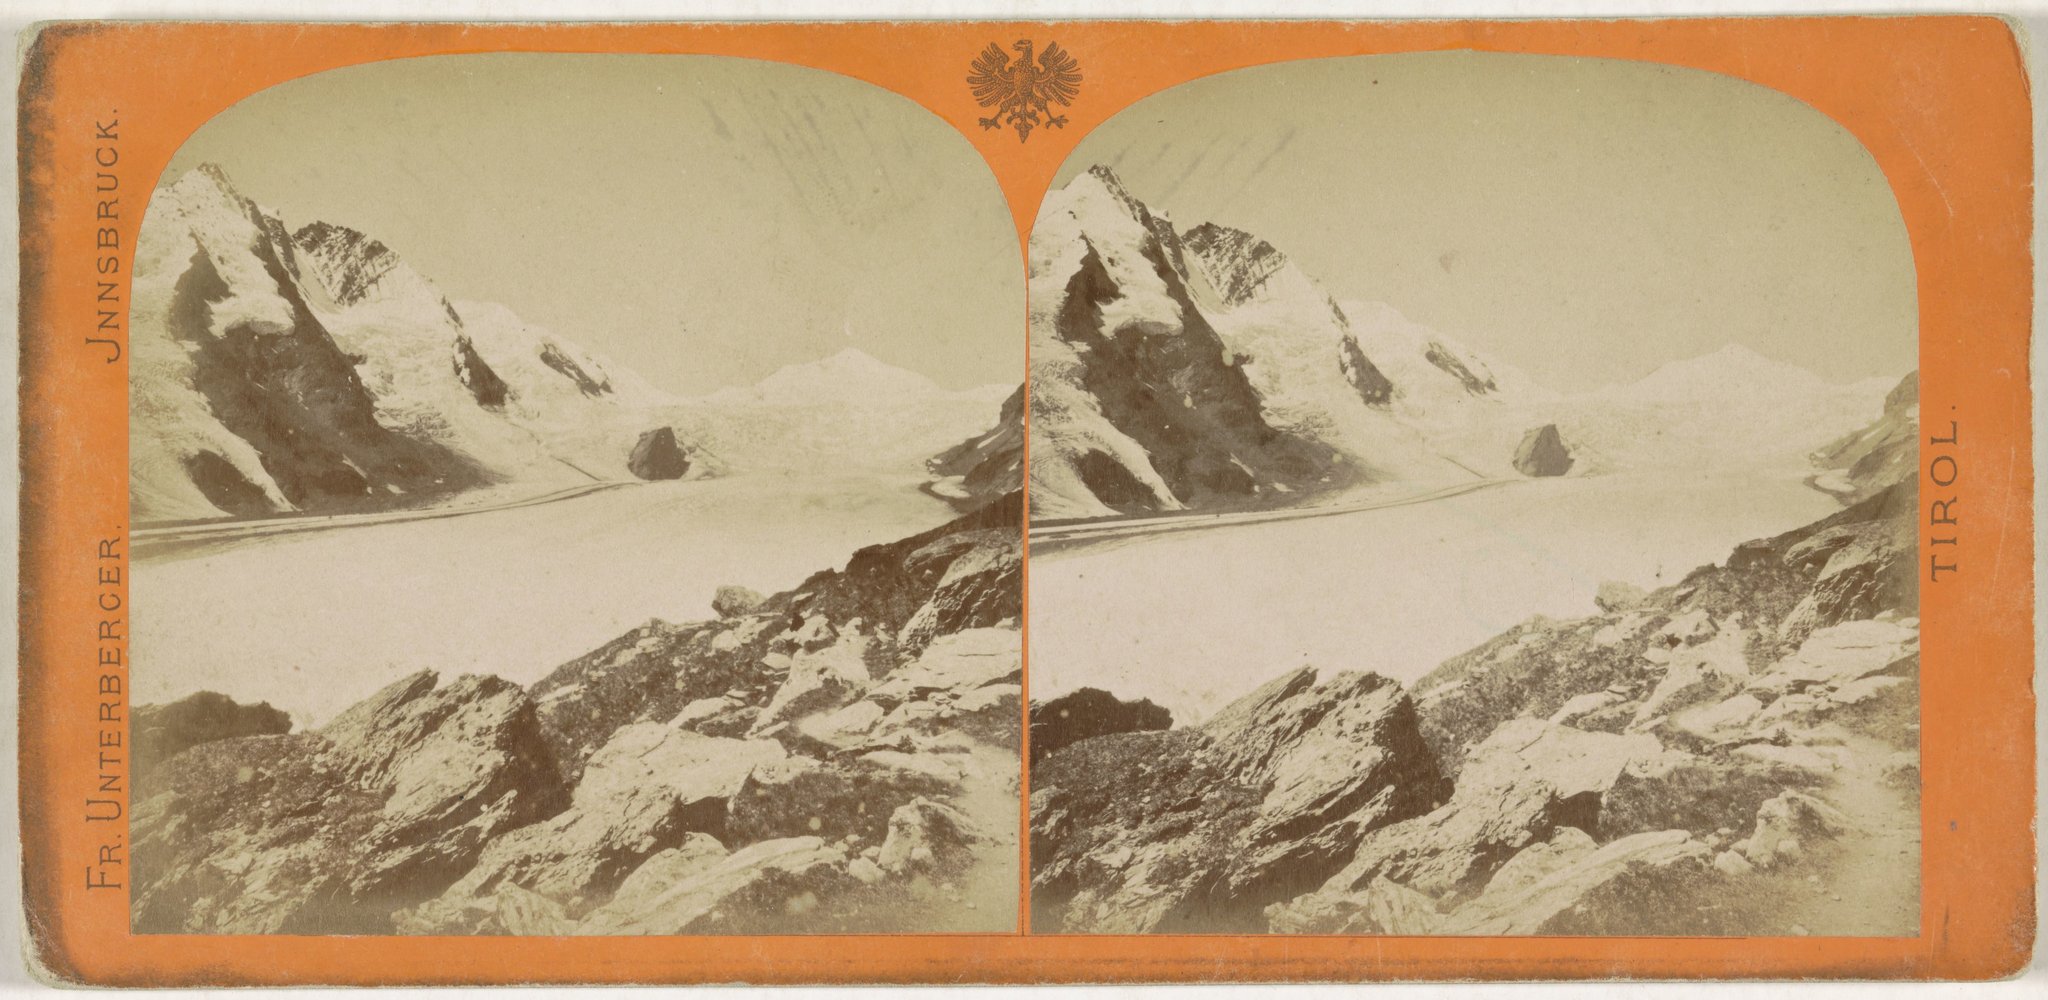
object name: stereograph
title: Gezicht op de Großglockner (links) en de Johannisberg (rechts), met op de voorgrond de Pasterzegletsjer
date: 1861-1867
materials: cardboard, paper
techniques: albumen print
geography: pasterze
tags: glacier, mountains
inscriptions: number: ‘341’